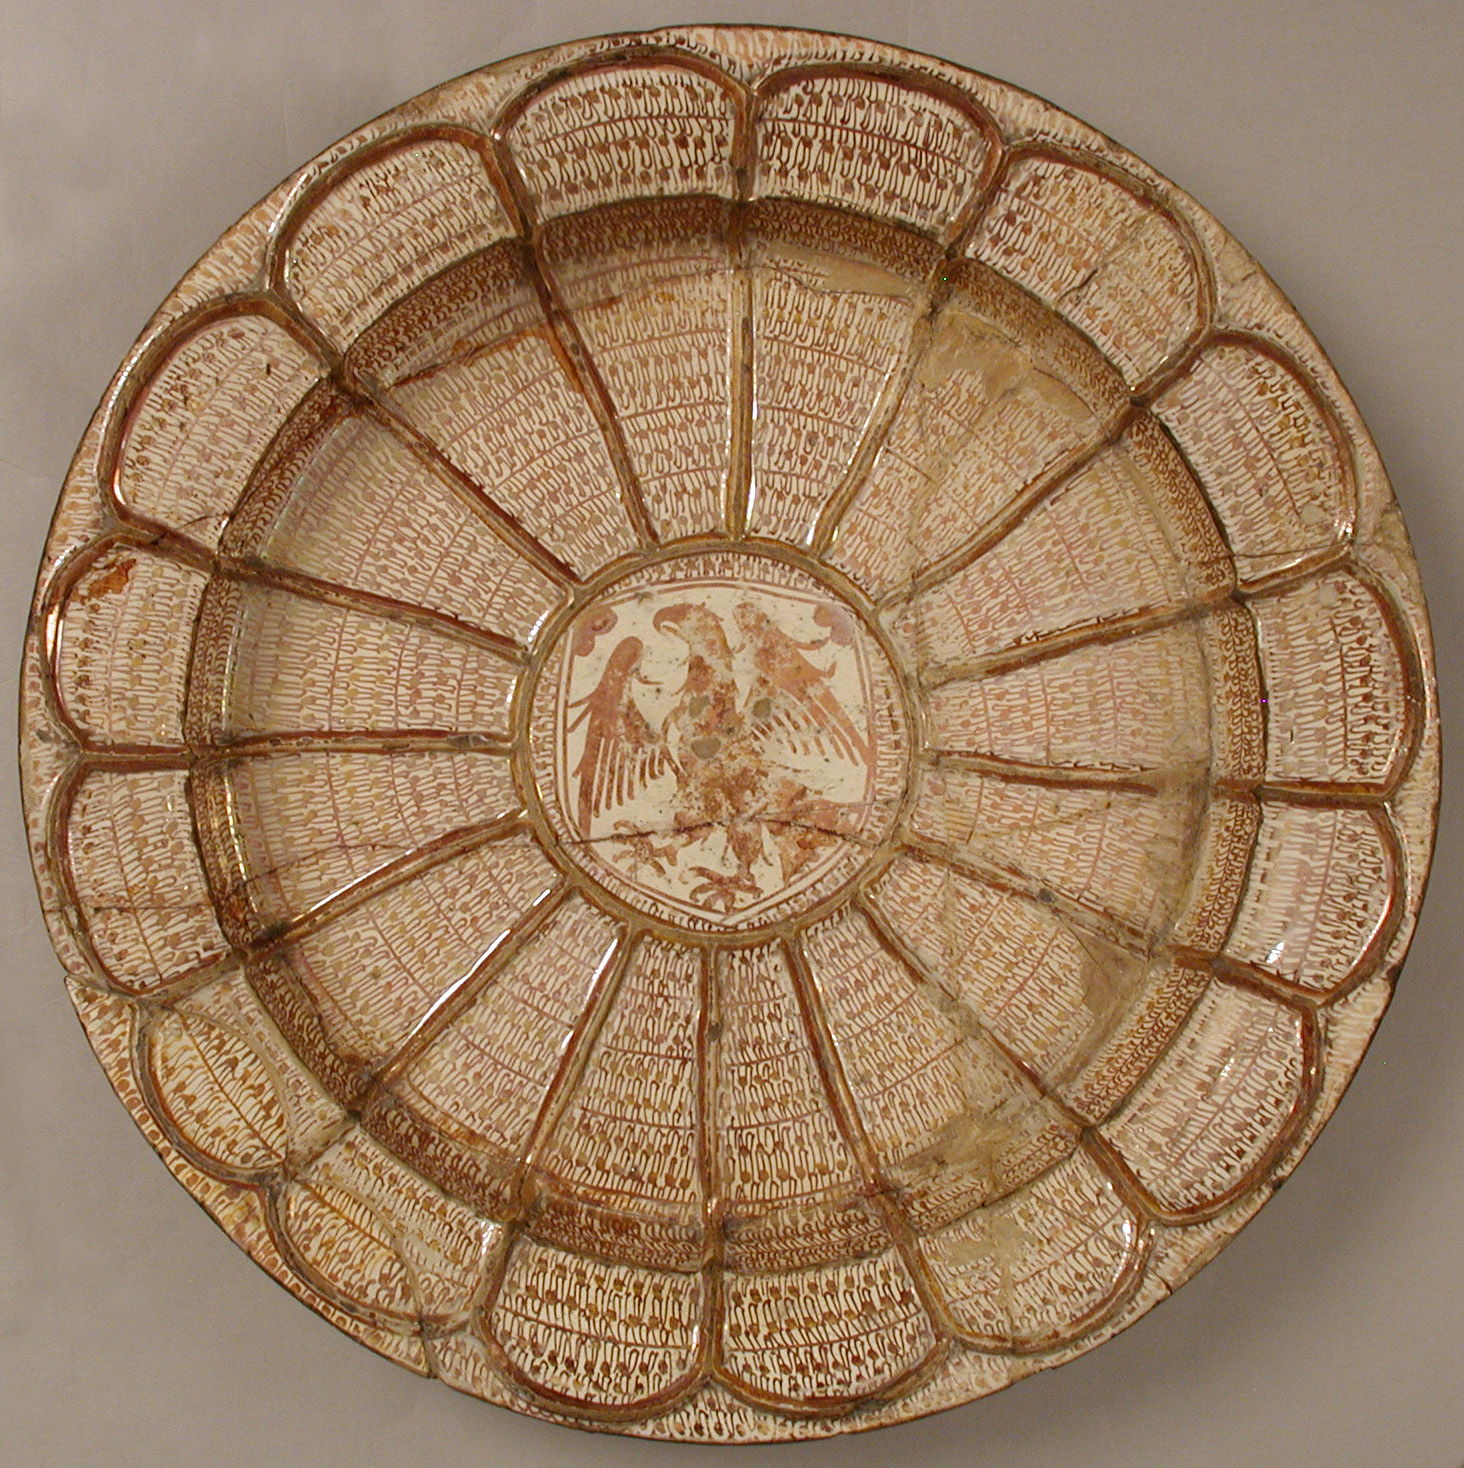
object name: plate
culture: spanish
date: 1500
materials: earthenware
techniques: glazing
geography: spain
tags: birds